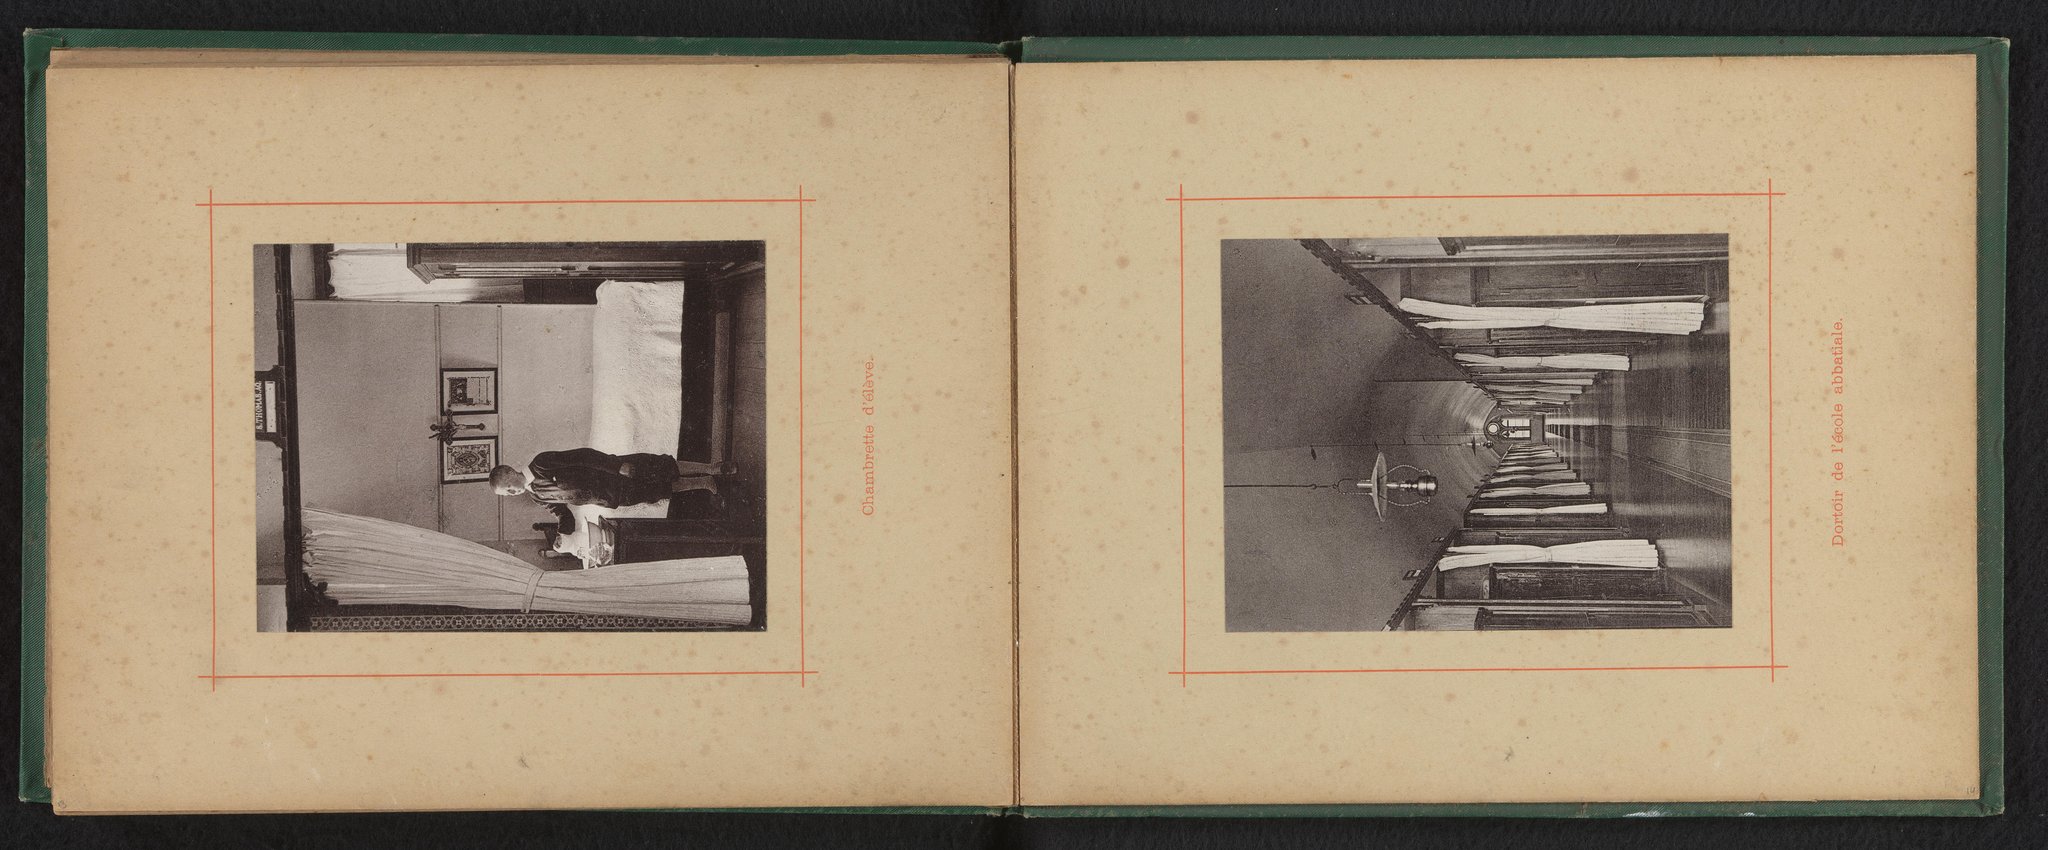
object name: photomechanical print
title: Chambrette d'élève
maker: Anonymous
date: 1900-1905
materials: paper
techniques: photograph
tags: student room, abbey, monastery, convent ~ roman catholic church